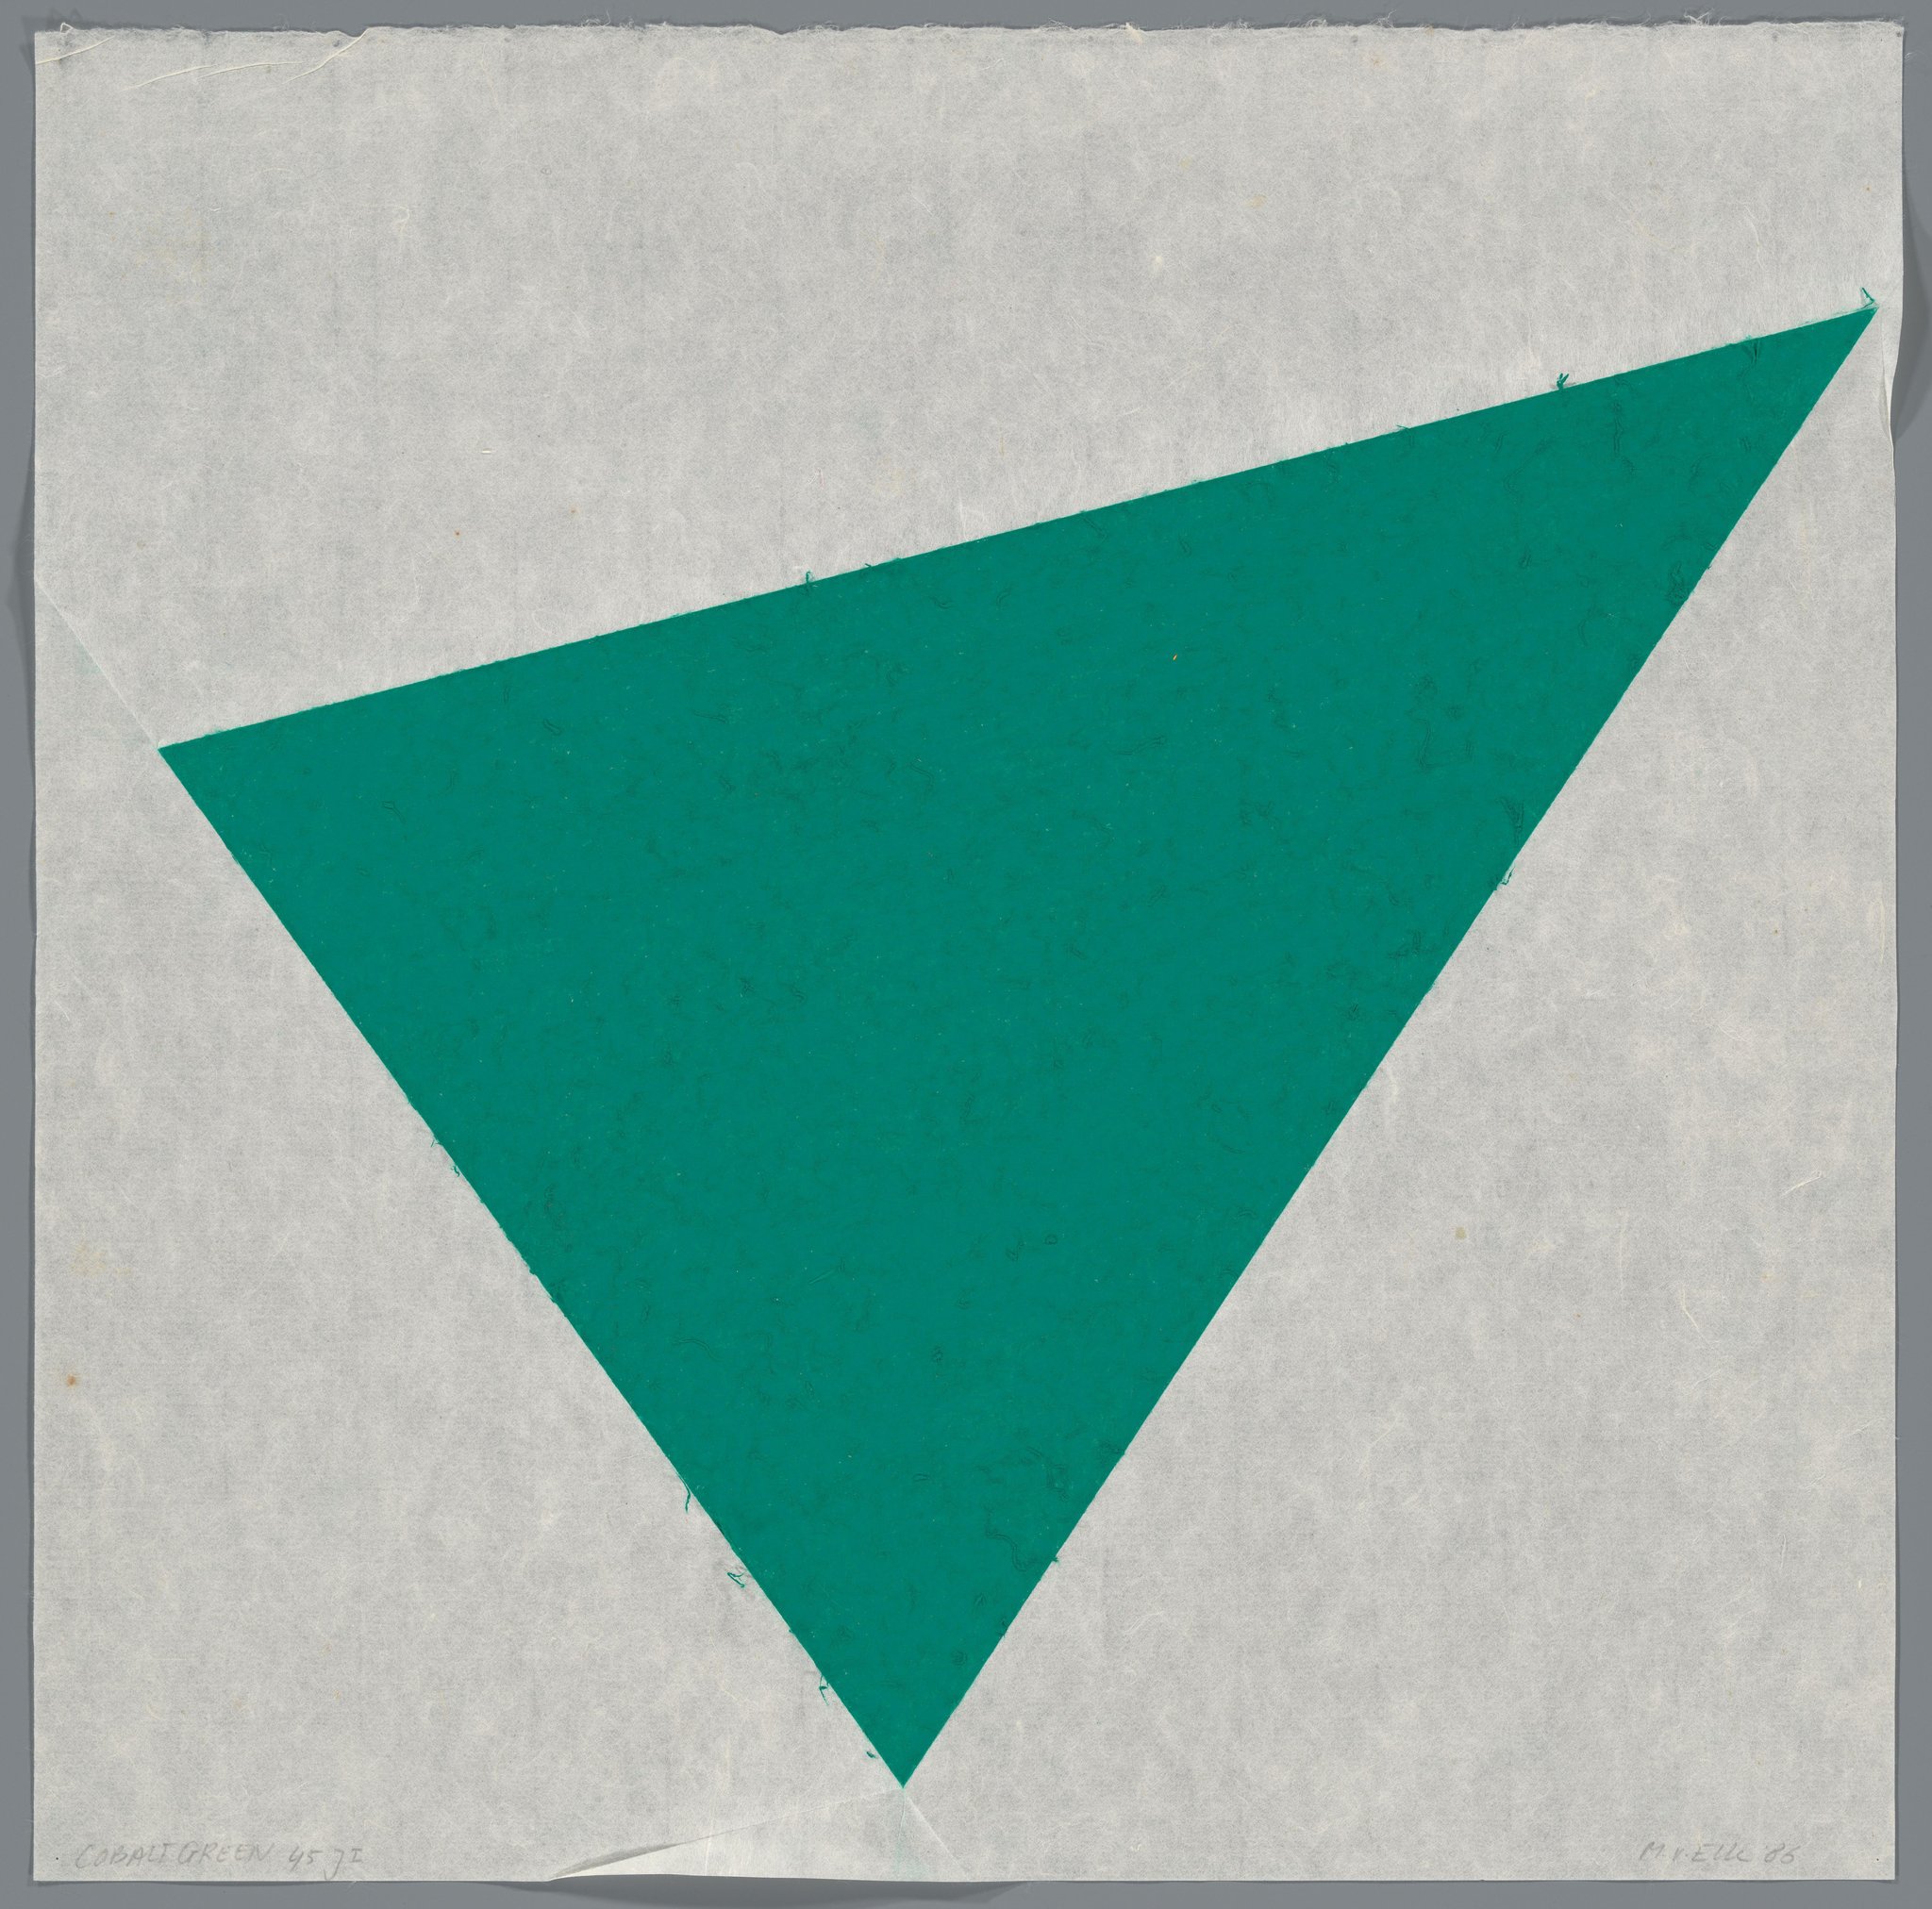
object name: drawing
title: Folded Geometric Shapes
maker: maria van elk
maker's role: artist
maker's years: 1943-2025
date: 1986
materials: paper, pastel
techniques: drawing, folding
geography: netherlands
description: In 1986 Maria van Elk folded eight sheets of thin paper into different shapes, each with its own colour. As a result, colour and shape enter into a relationship. It suddenly appears that green makes a more spatial effect than red and a triangle a wider impression than a hexagon. Like Ellsworth Kelly (whose sculptures are now on display in the Rijksmuseum Gardens), Van Elk merges colour and shape.